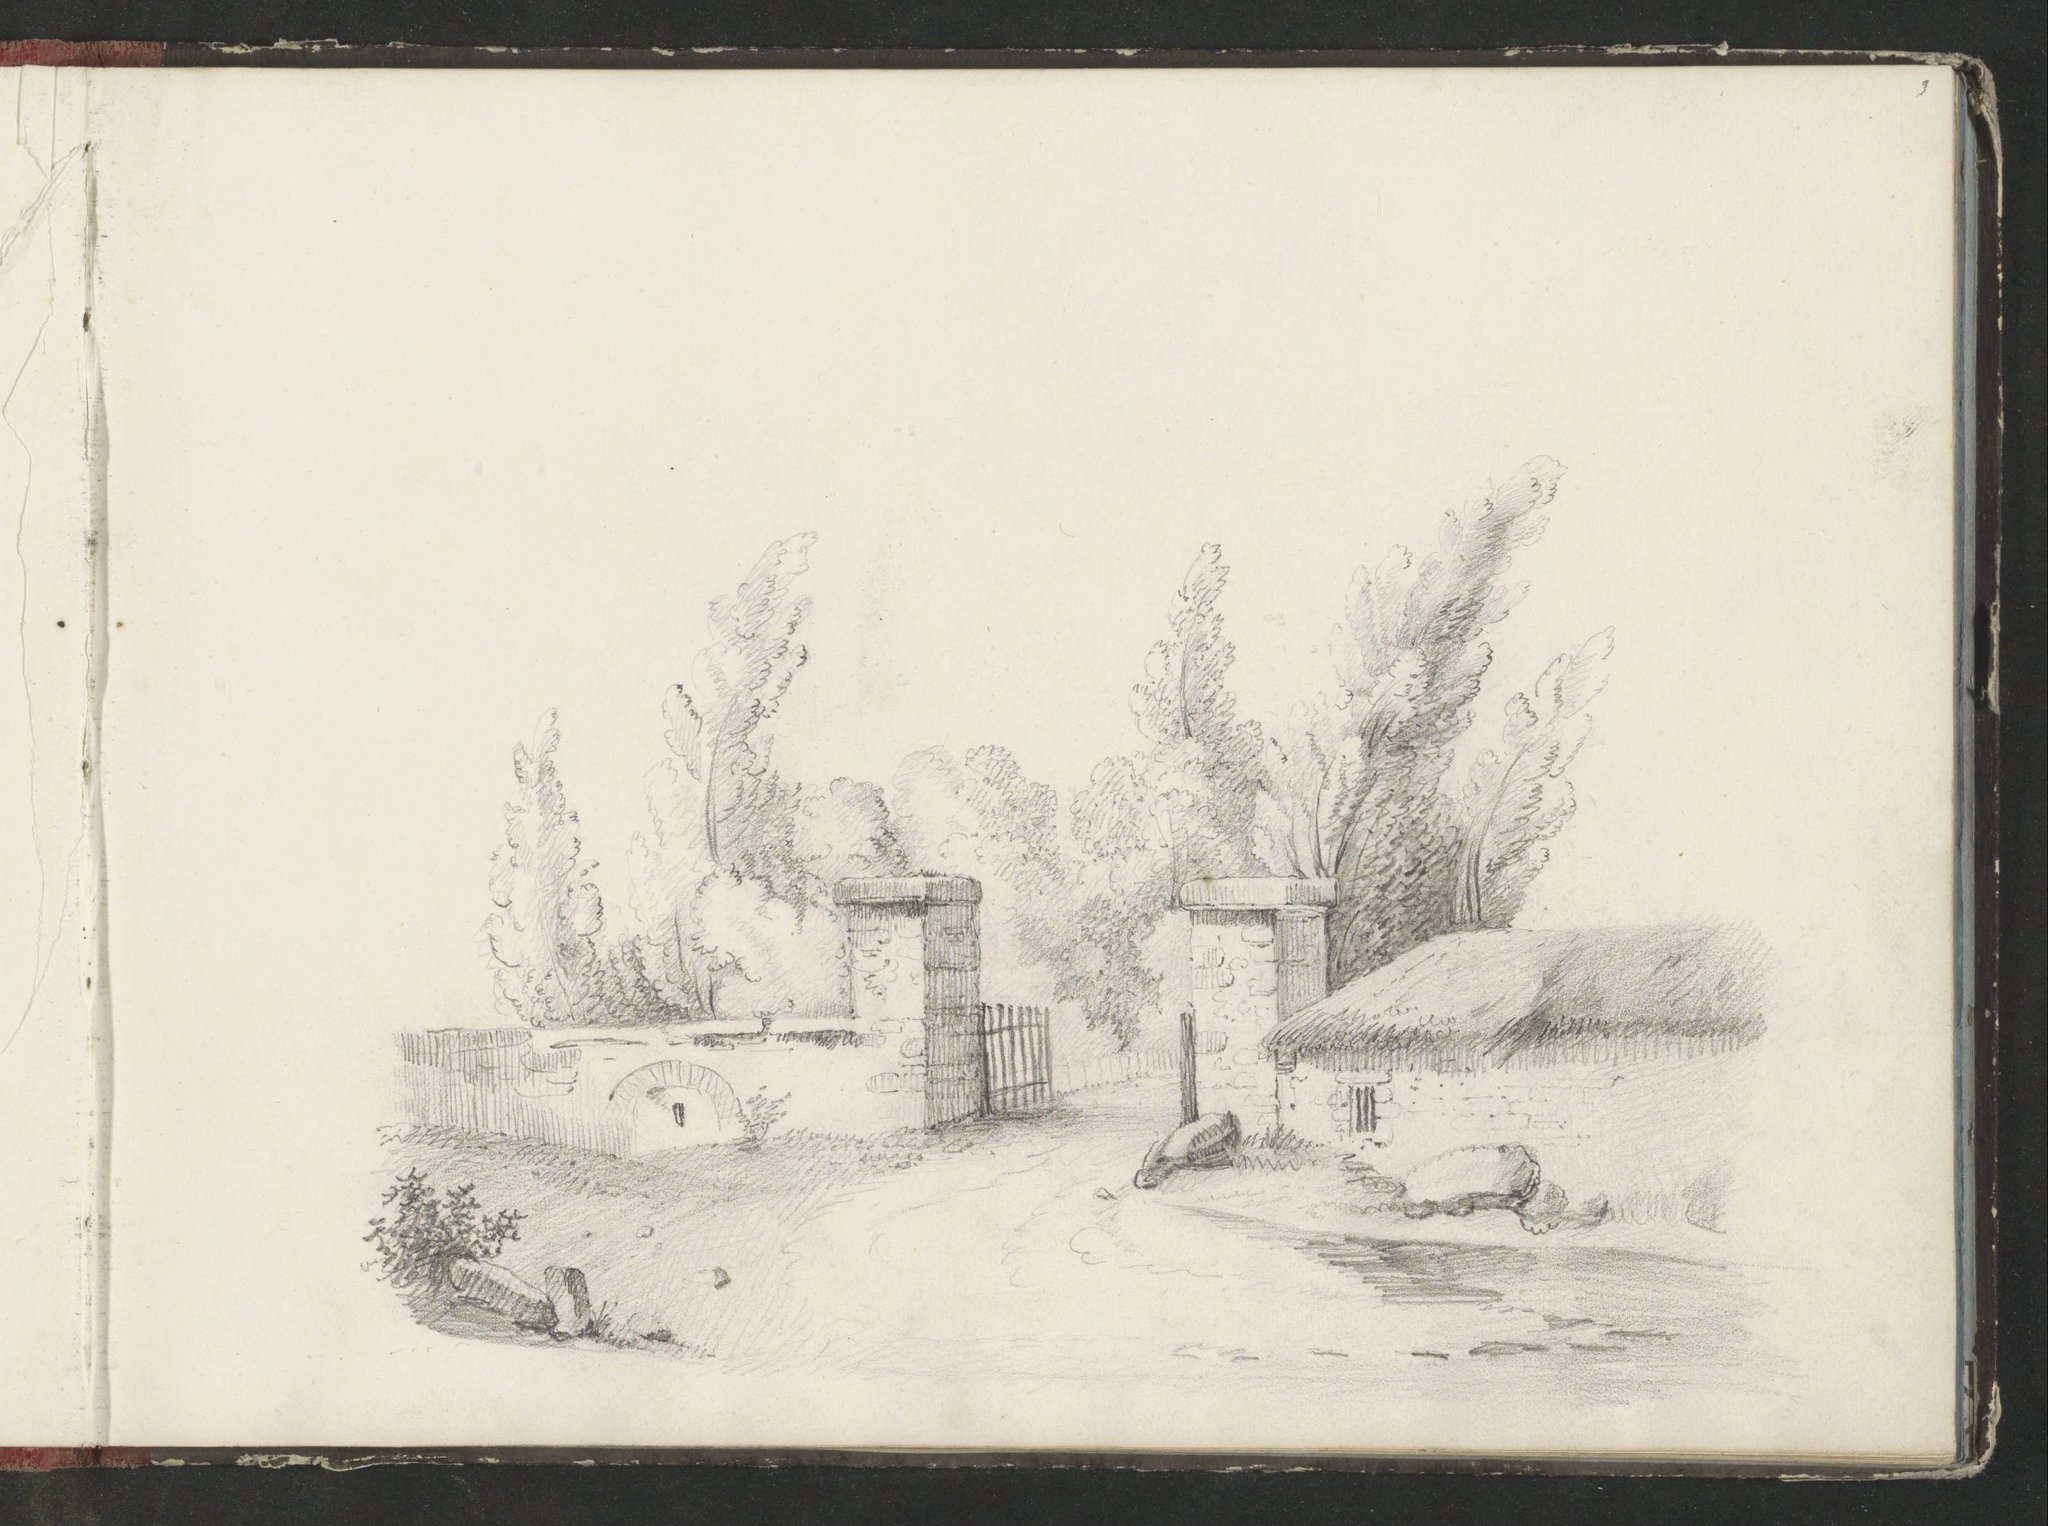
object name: sketchbook leaf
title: Toegangspoort aan een pad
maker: Anonymous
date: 1819-1870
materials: paper, pencil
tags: fence, wall, paling, gate, entrance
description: Blad 9 recto uit een schetsboek met 39 bladen.